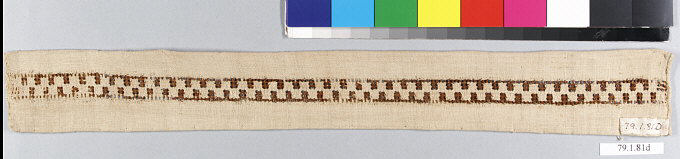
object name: strip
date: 1501-1600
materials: linen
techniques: embroidery